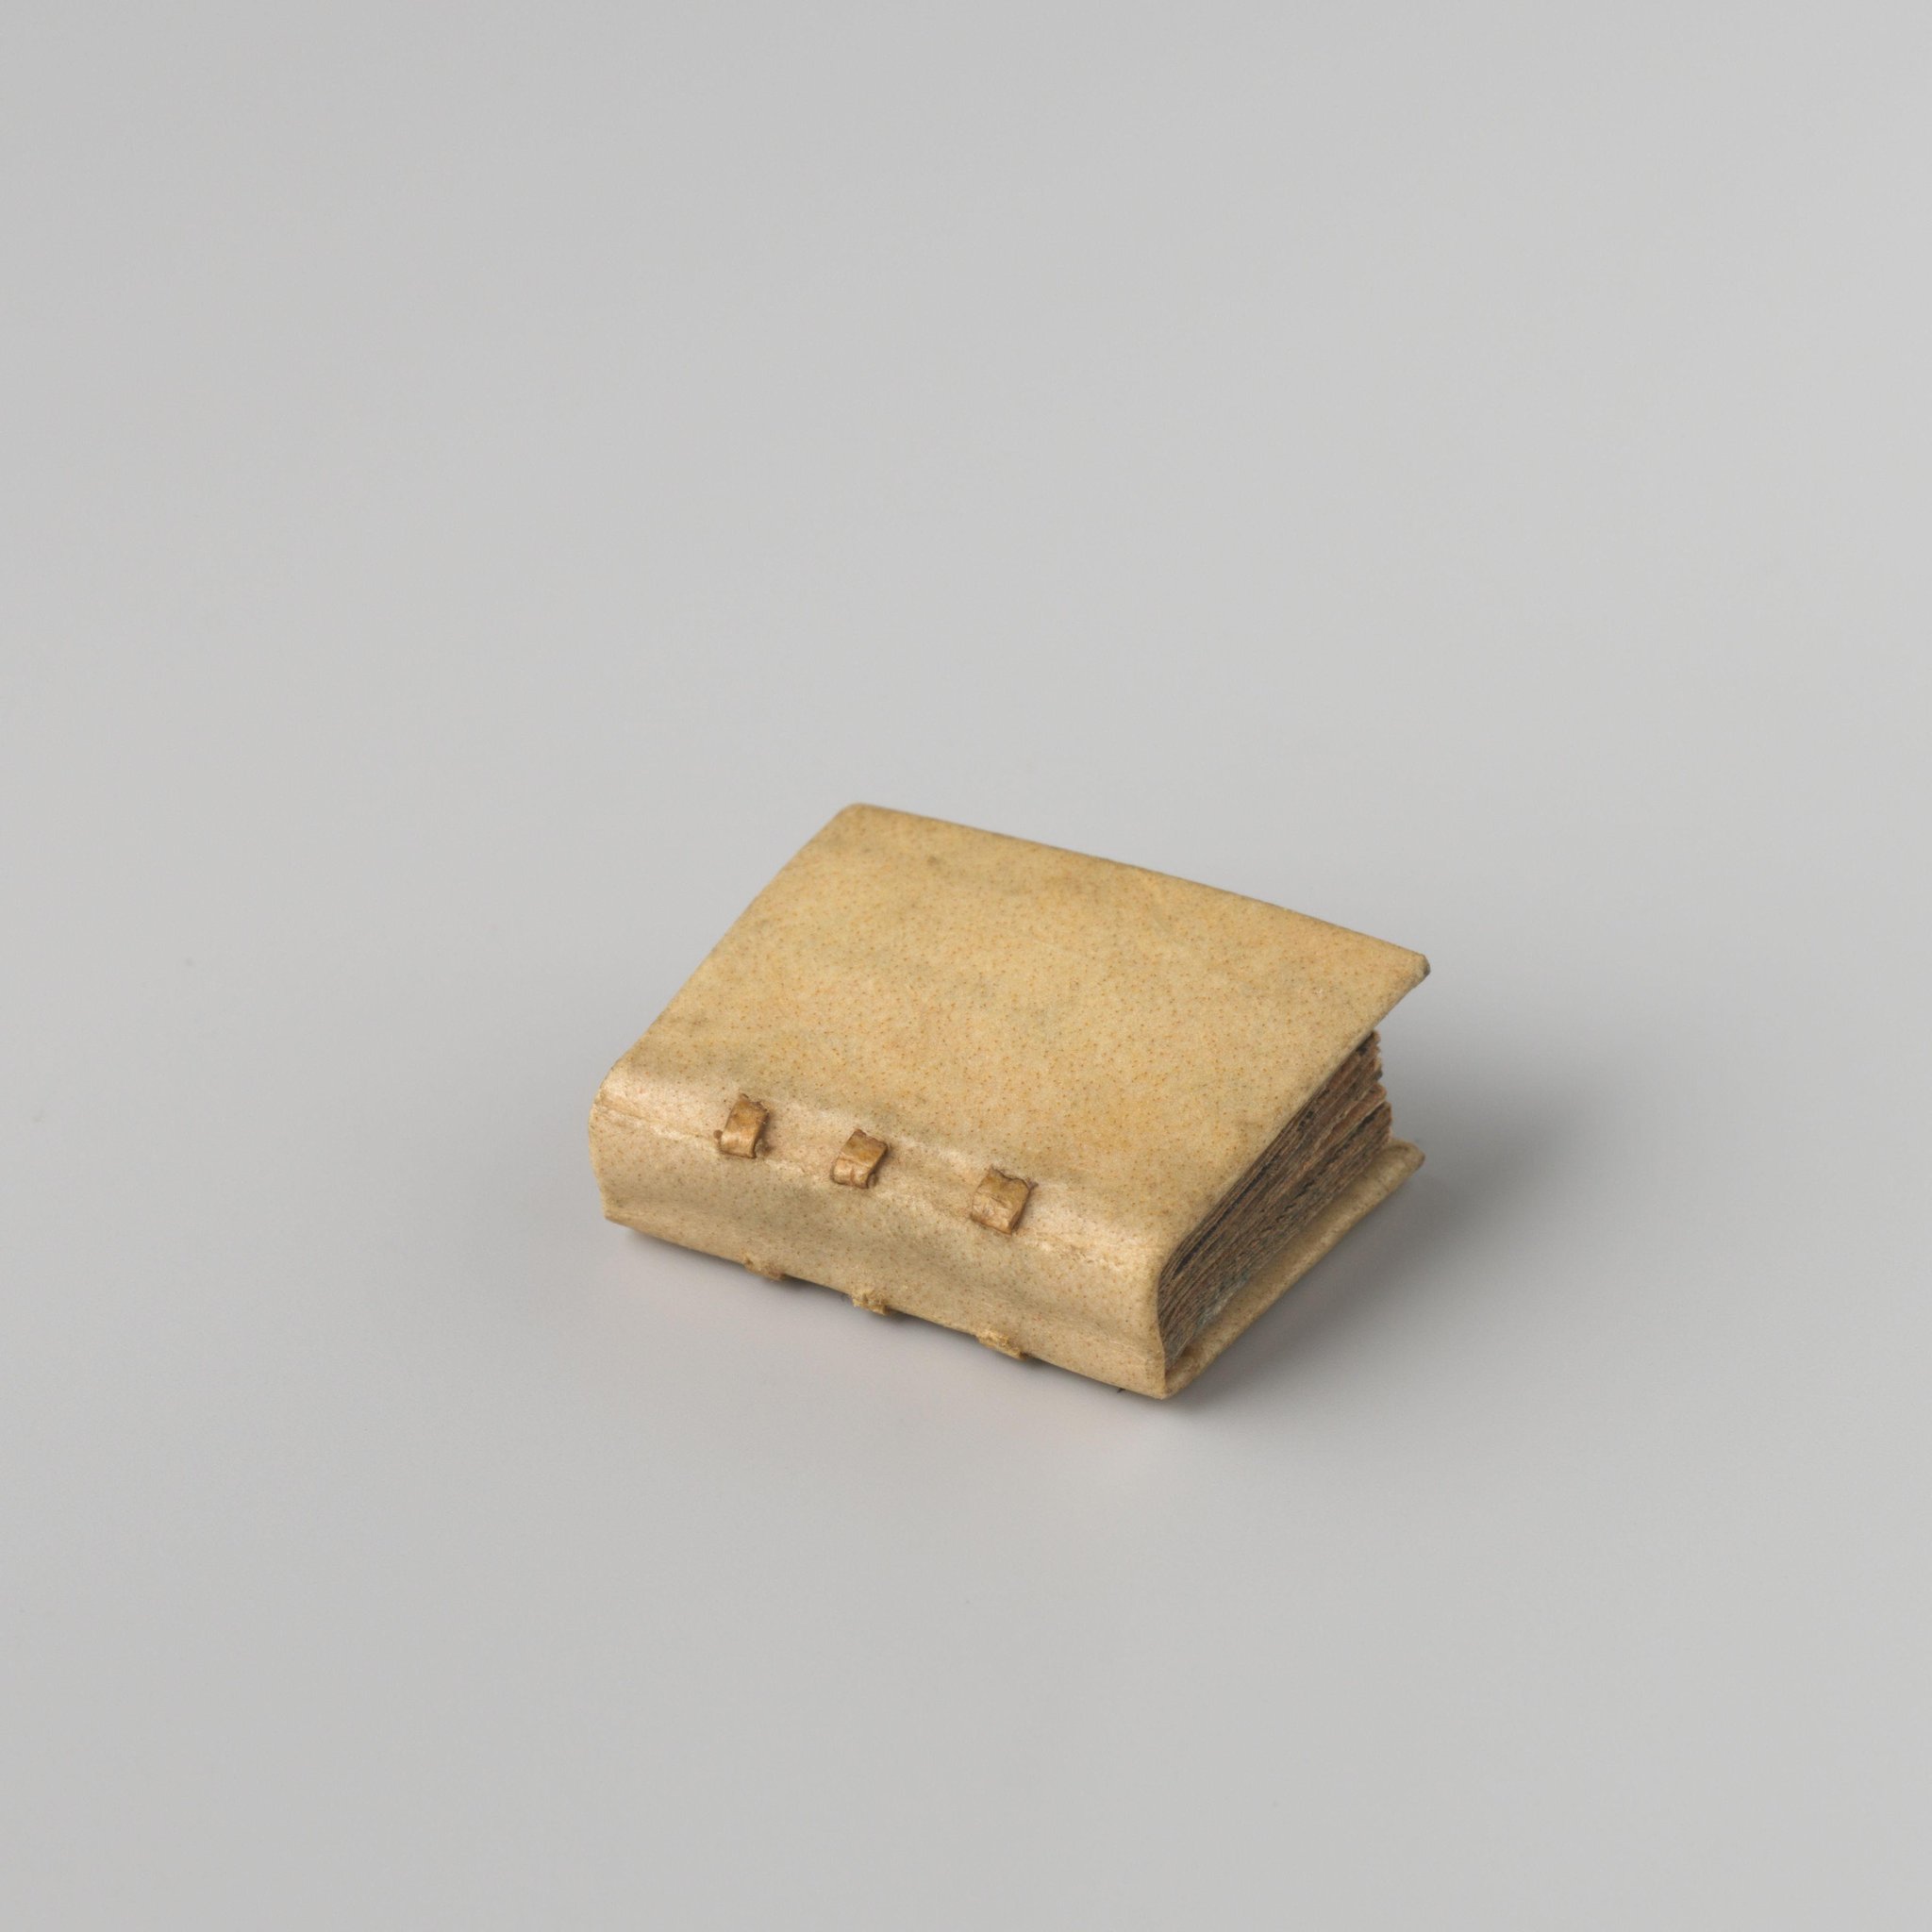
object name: book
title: Boek met tuingezichten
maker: Anonymous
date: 1690-1710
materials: paper, parchment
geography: amsterdam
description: Boek met tuingezichten. Ingebonden in blank perkament.